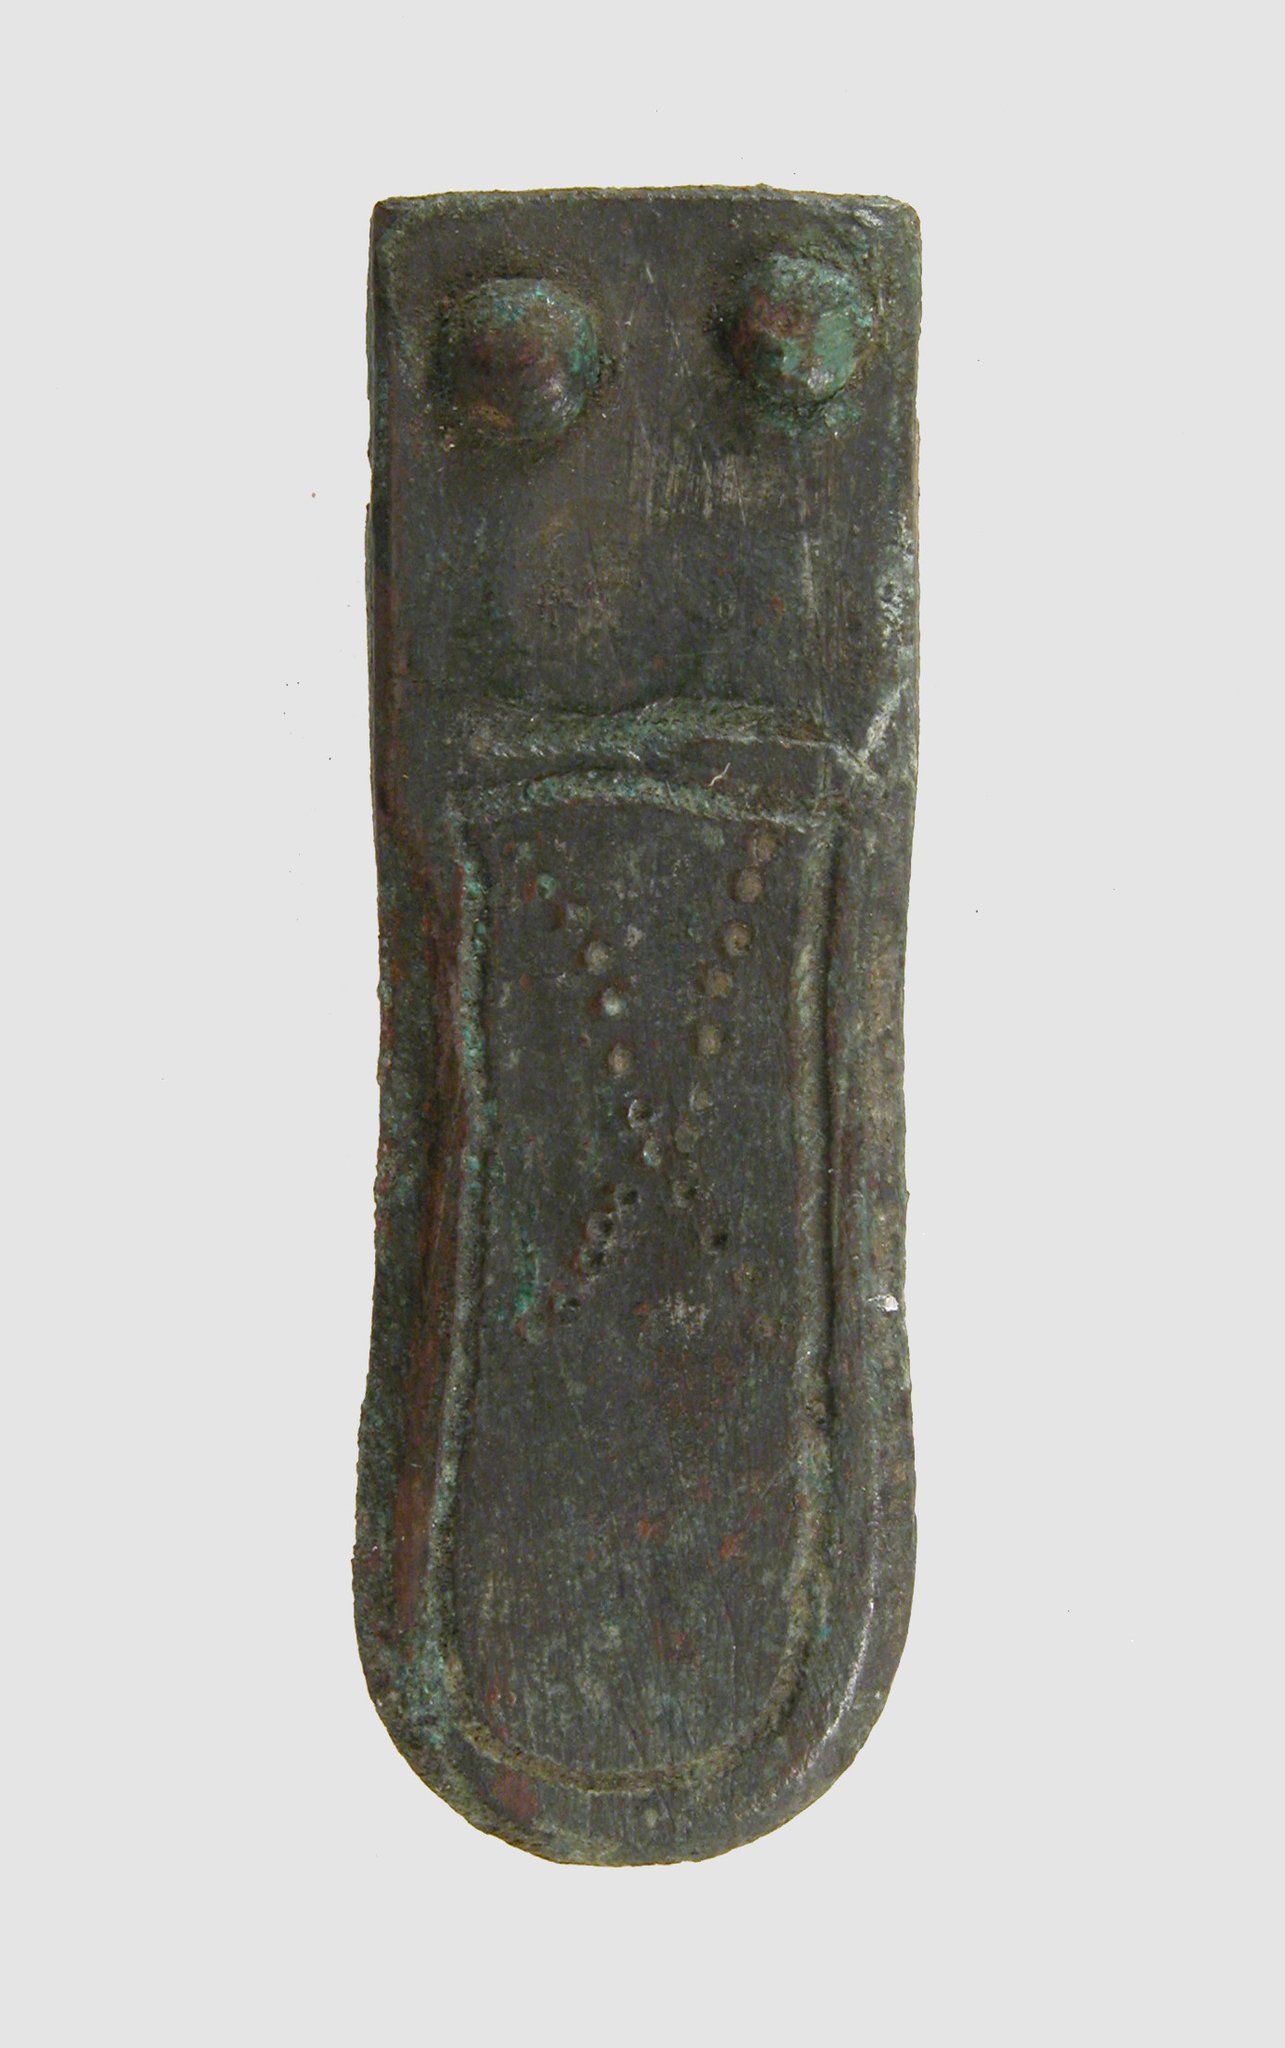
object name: ferret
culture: frankish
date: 501-700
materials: copper alloy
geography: germany